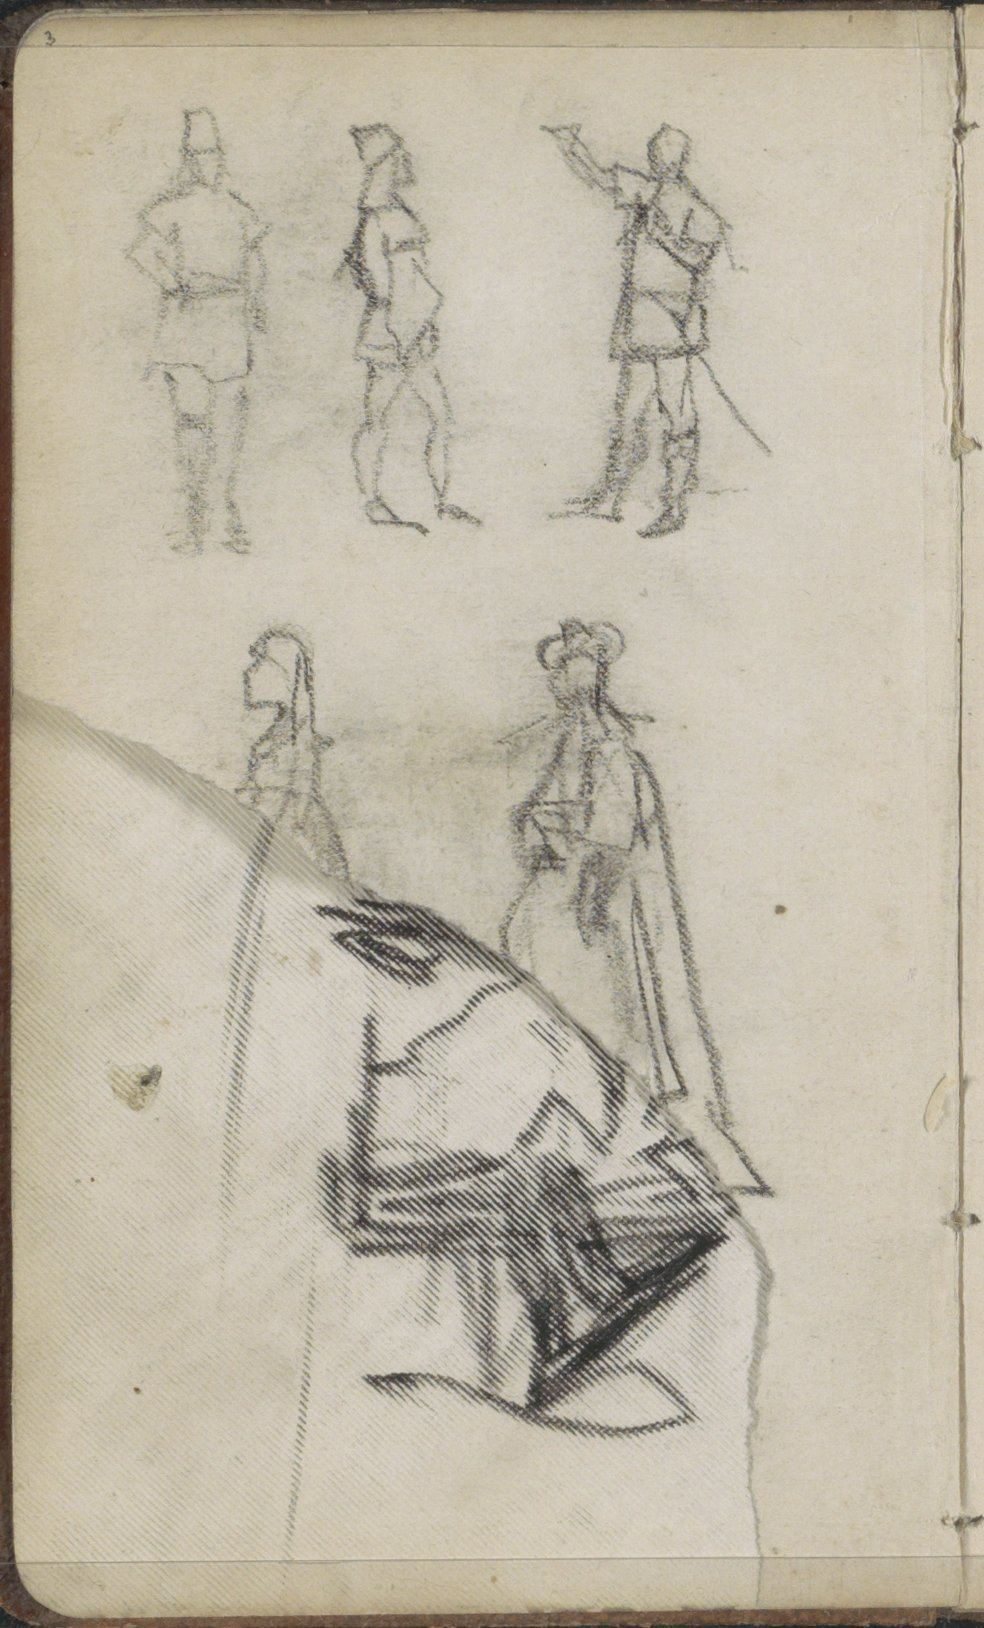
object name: sketchbook leaf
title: Figuurstudies van een soldaat en jonkvrouw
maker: marius bauer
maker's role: draughtsman, print maker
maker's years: 1867-1932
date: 1879-1885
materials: chalk, paper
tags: standing figure, adult woman, head-gear (with name), adult man, hacking and thrusting weapons: sword, historical costume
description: Pagina 3 uit een schetsboek met 58 bladen.